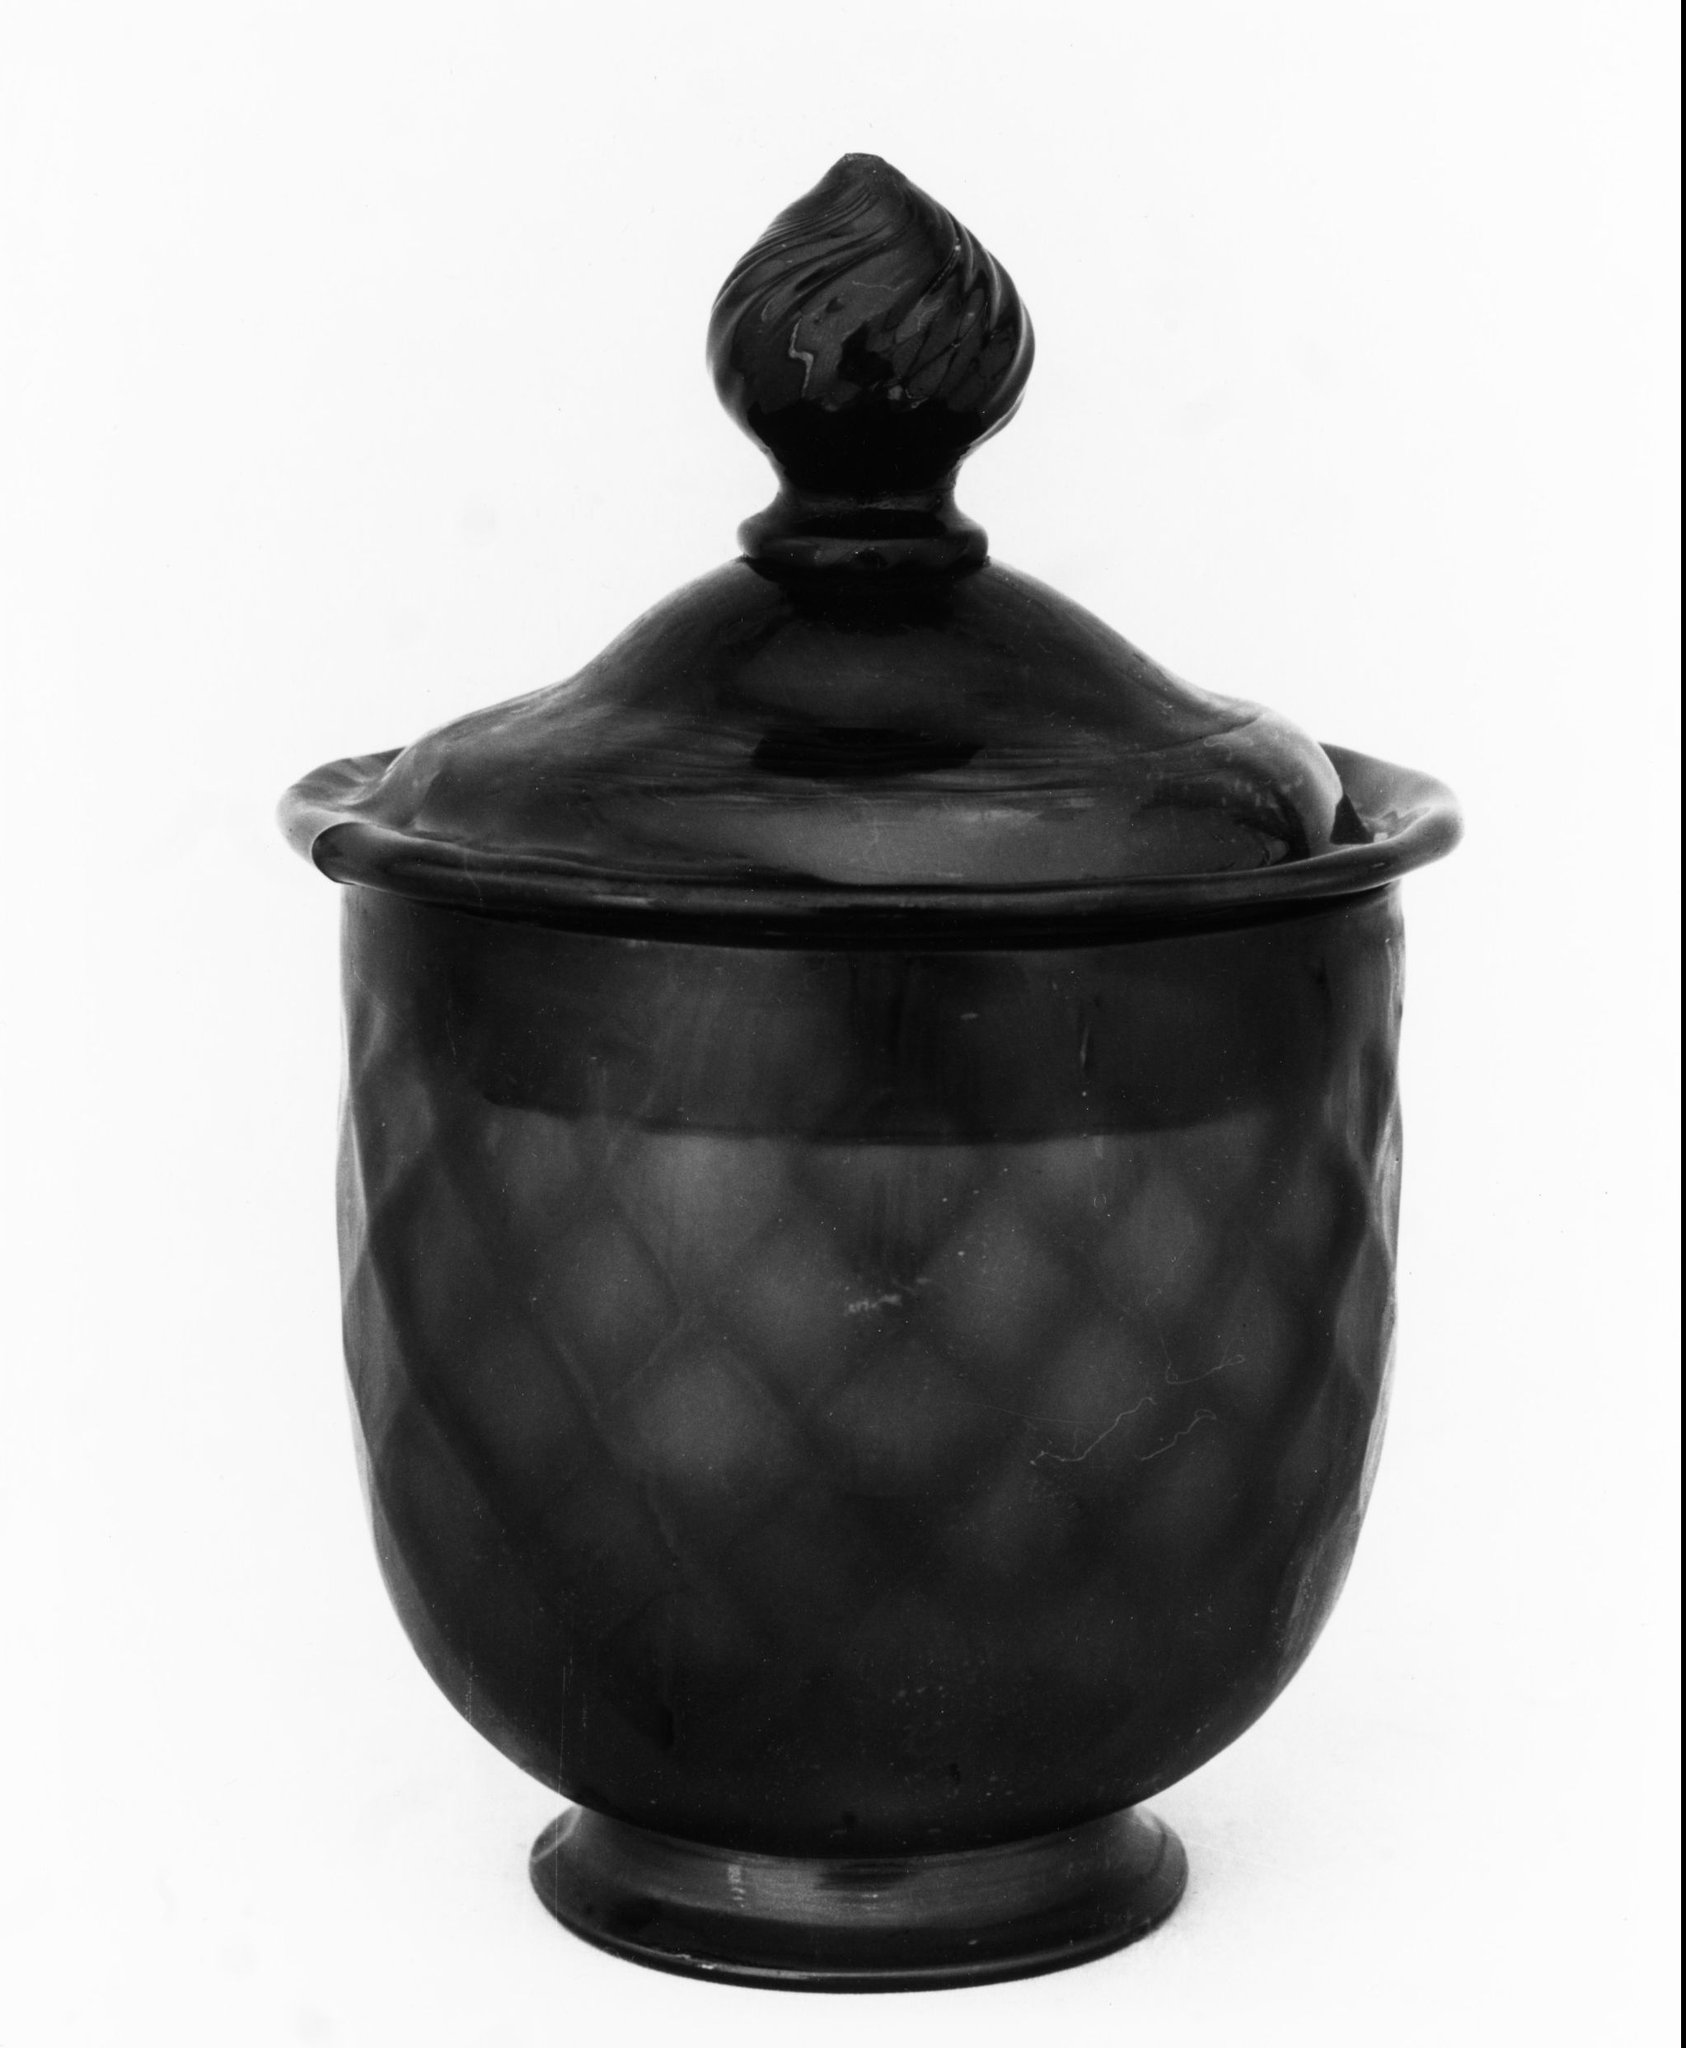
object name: sugar bowl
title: Covered Sugar Bowl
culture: american or british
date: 1780-1820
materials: glass, lead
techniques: glassblowing, molding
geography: england